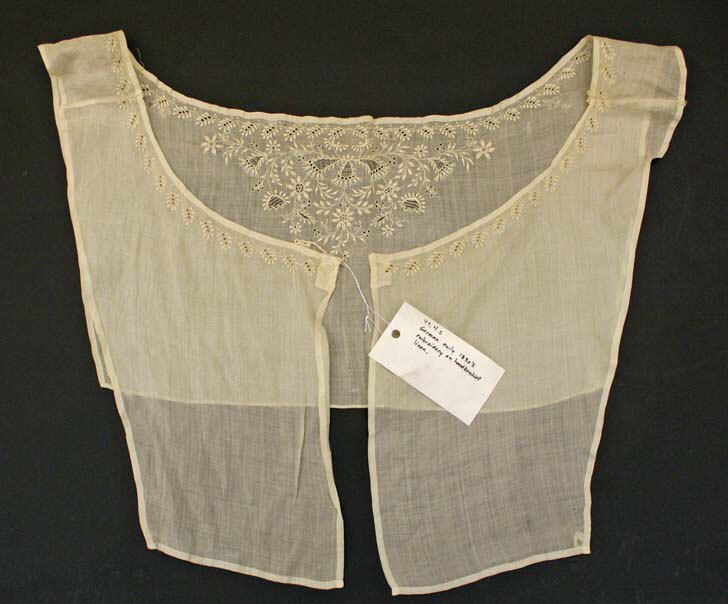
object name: chemise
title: Chemisette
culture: german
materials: linen